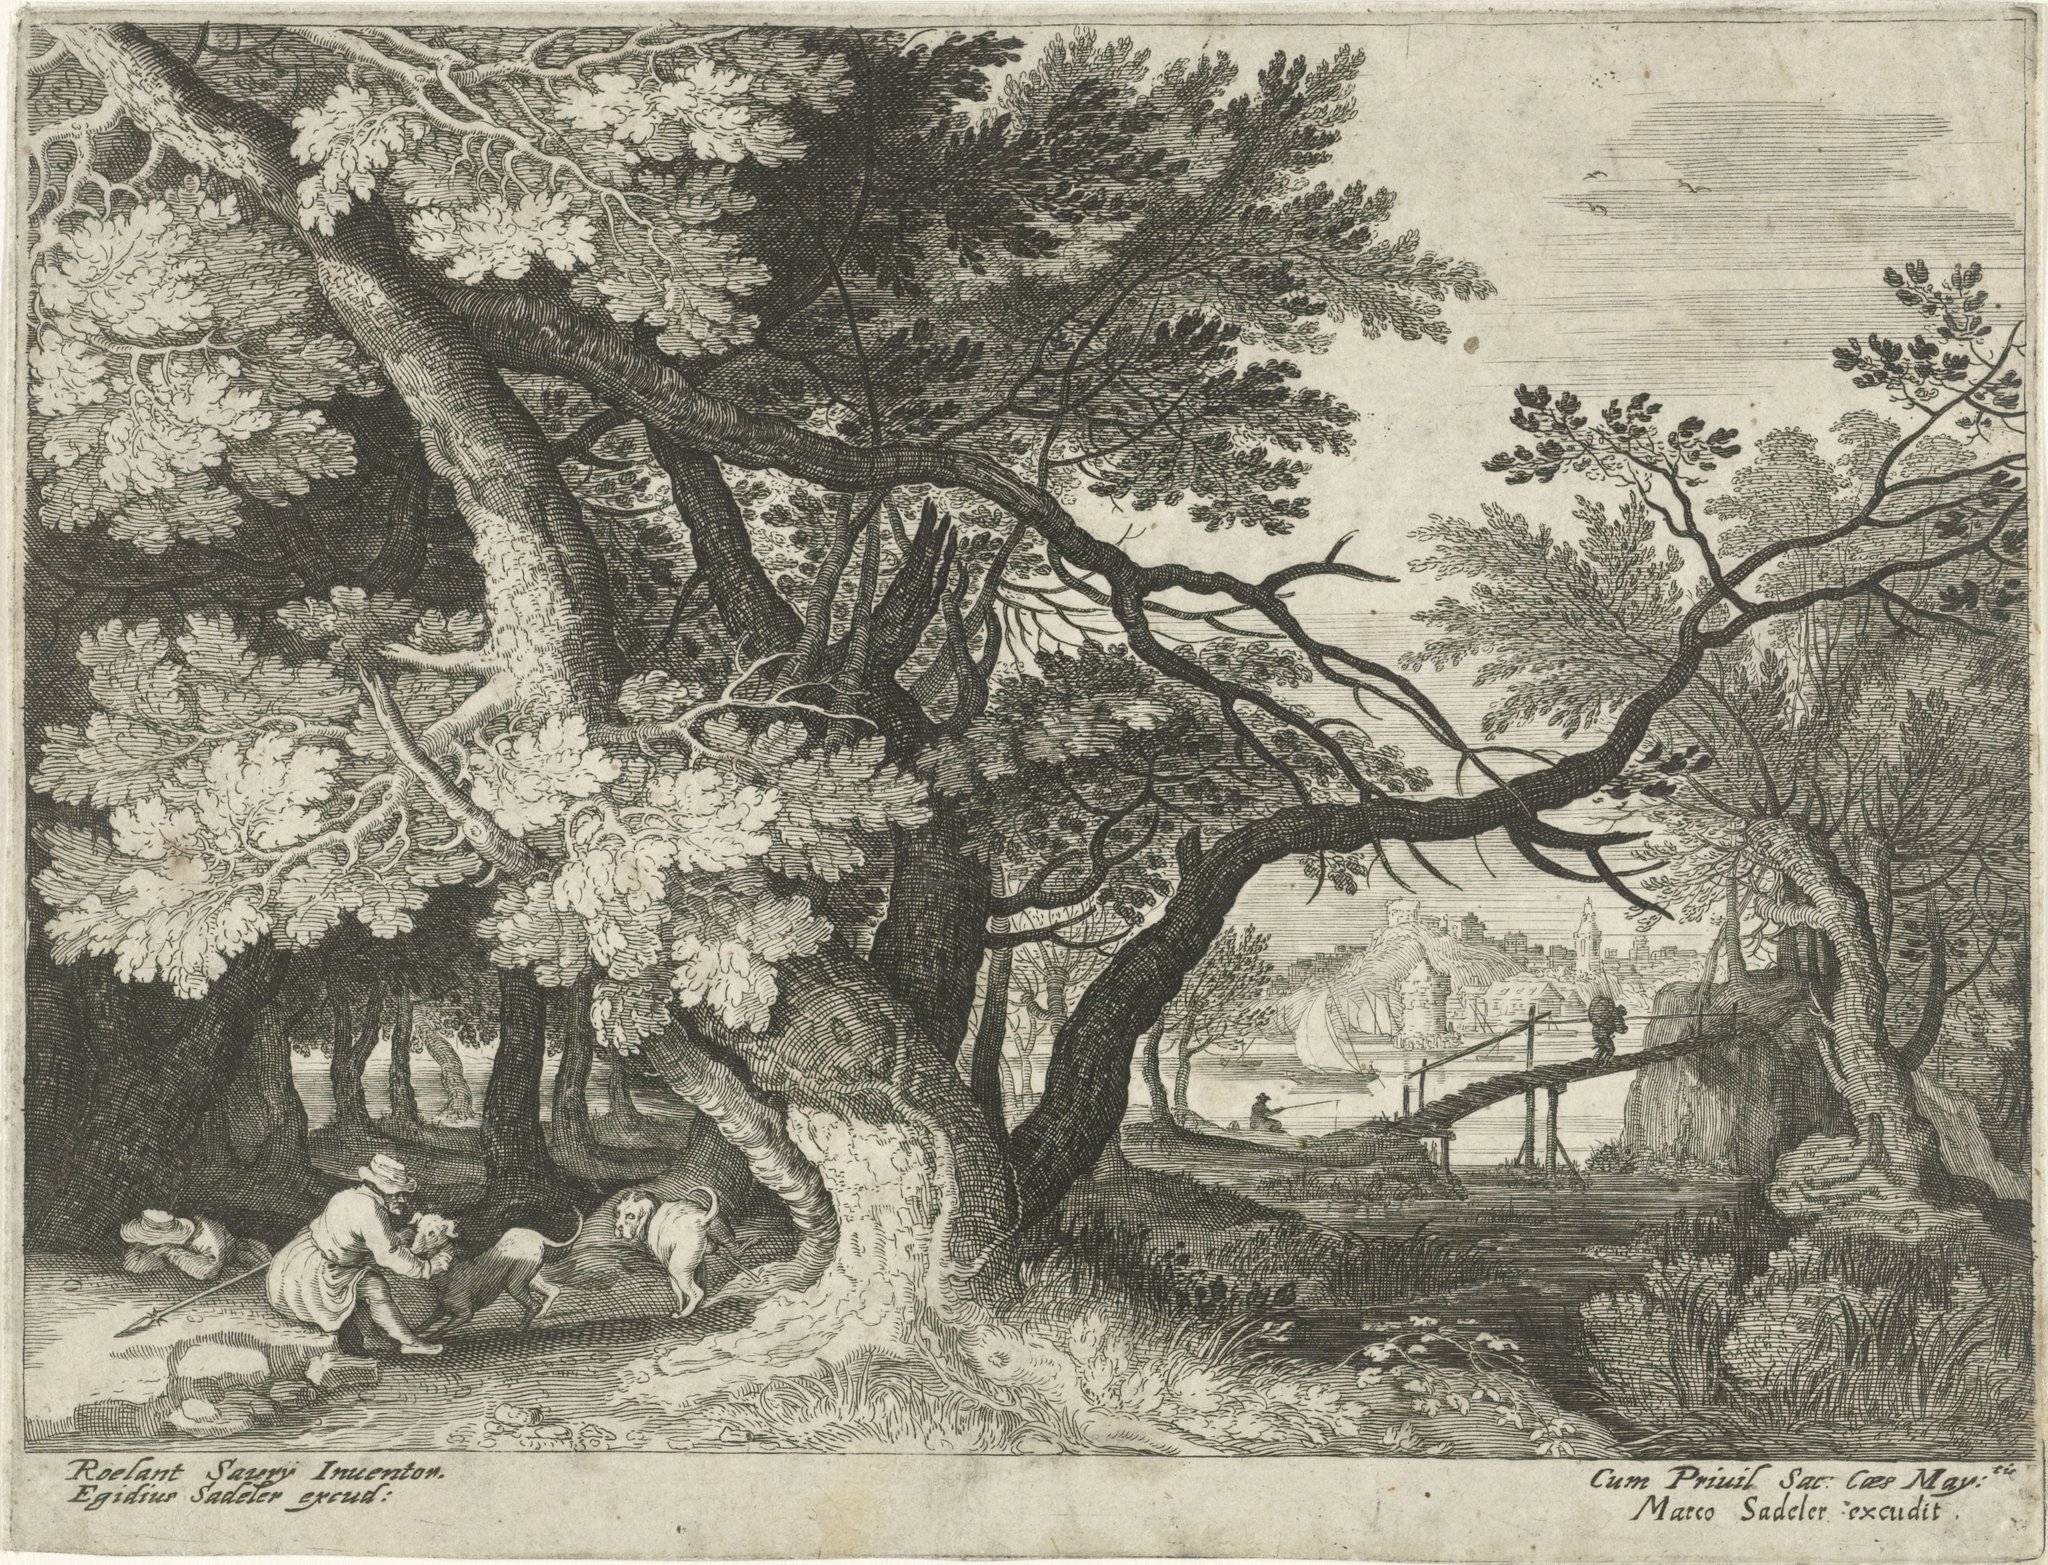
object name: print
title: Landschappen uit Tirol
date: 1580-1629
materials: paper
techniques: engraving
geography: prague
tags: hunting dogs, hunter, forest, wood, 'en route', traveller under way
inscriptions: collector's mark: Lugt 240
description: Boslandschap met op de voorgrond twee jagers. Een jager slaapt terwijl de ander met twee honden speelt. Rechtsachter een houten brug en een dorp. De eerste prent van een zesdelige reeks met landschappen uit Tirol.